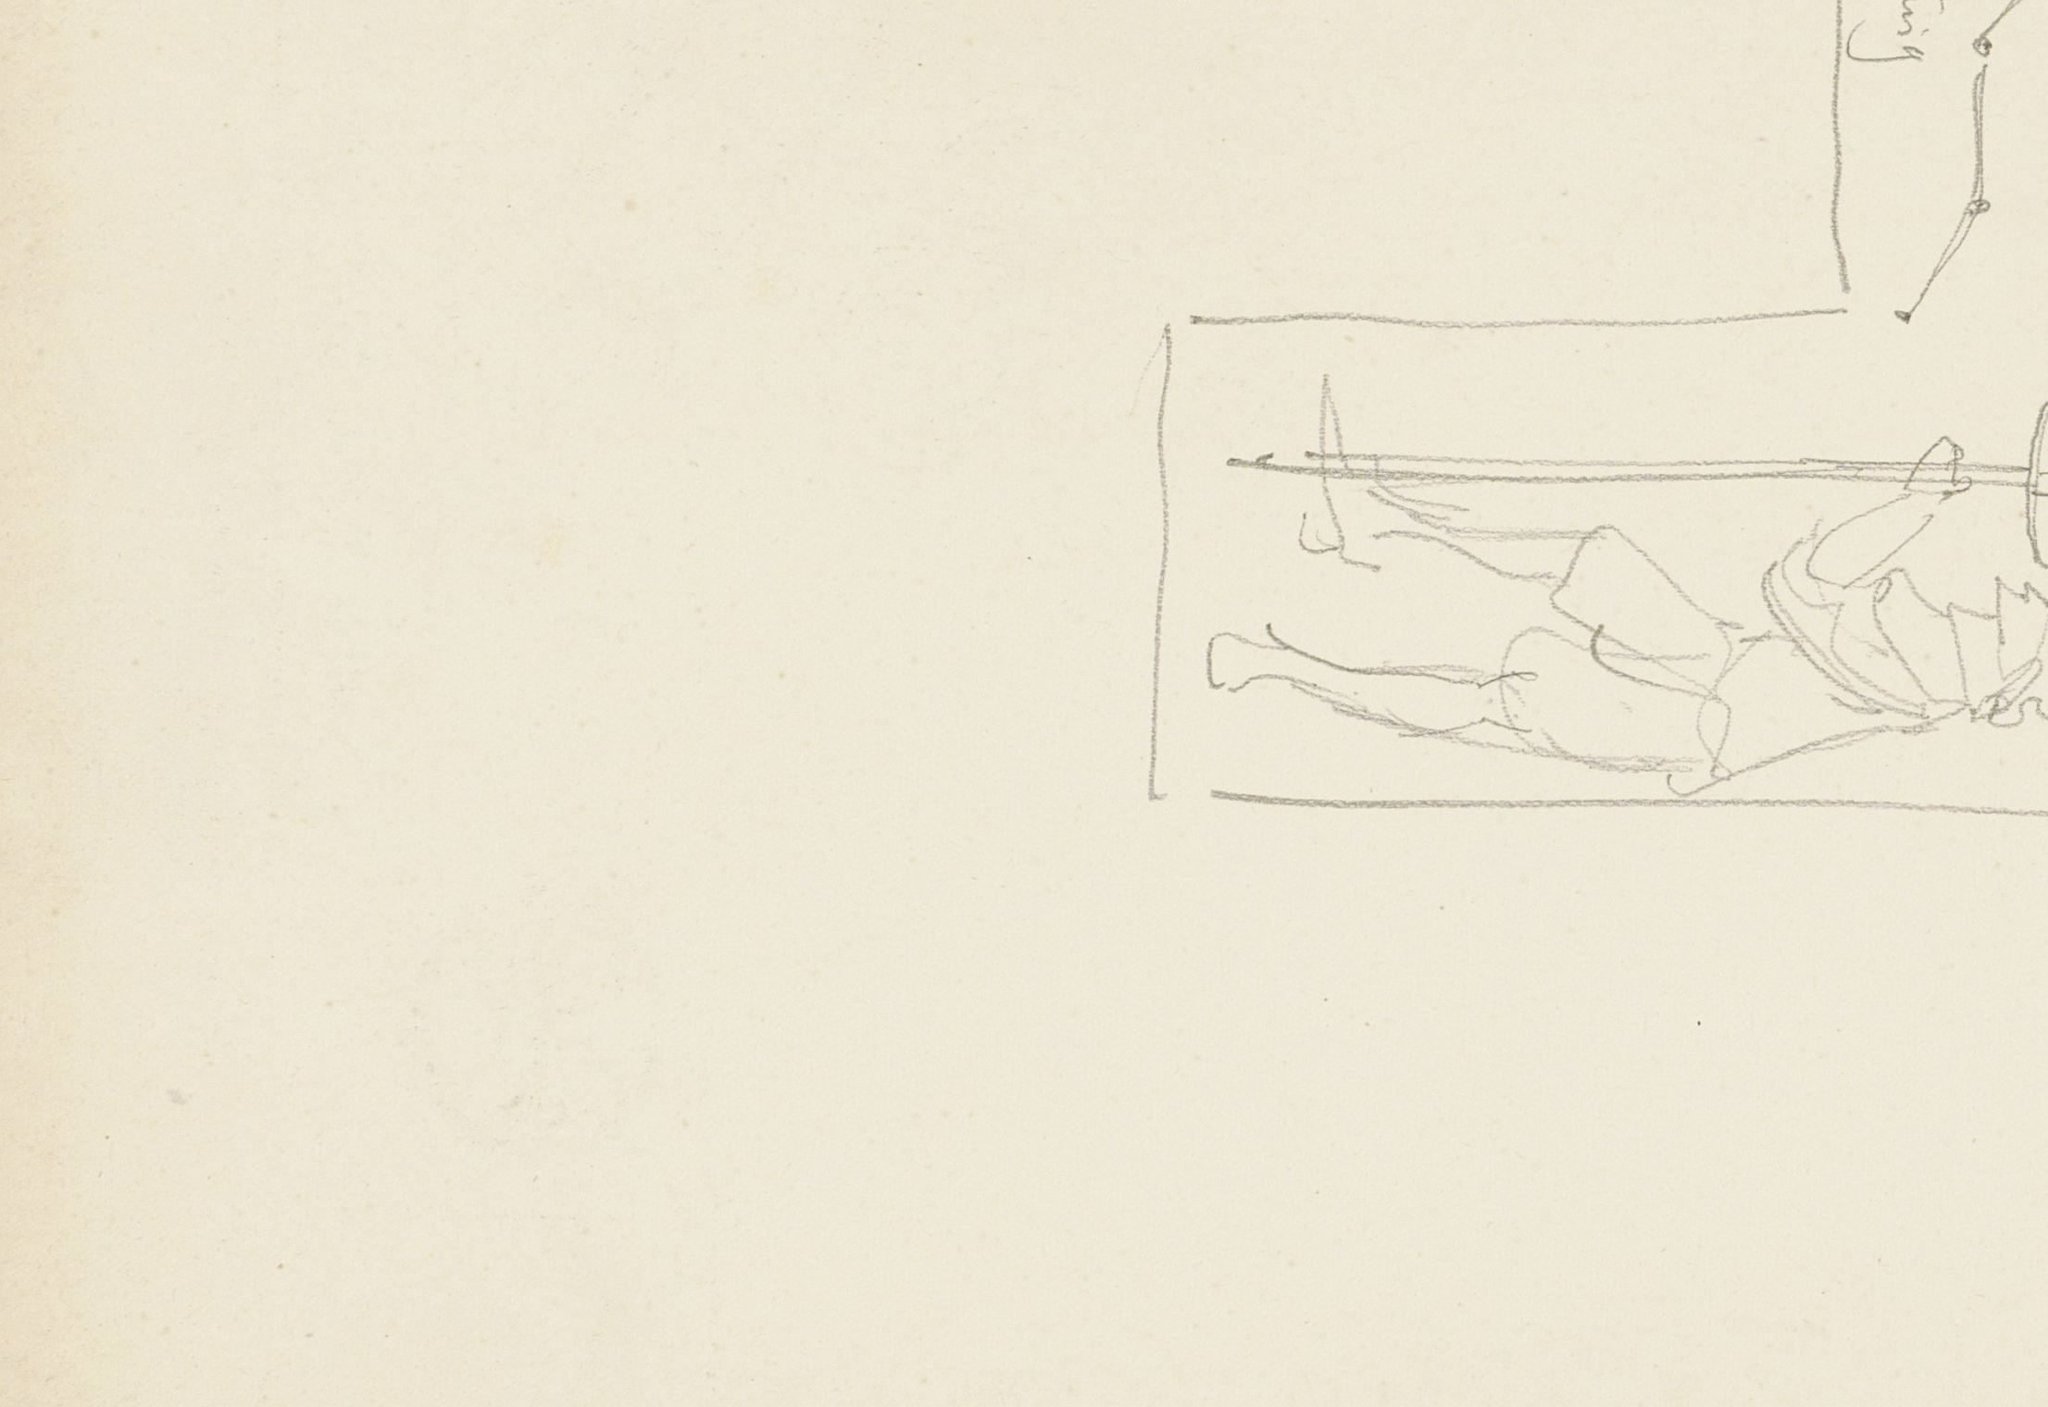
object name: sketchbook leaf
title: Man met die zonlicht opvangt met een optisch instrument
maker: antoon derkinderen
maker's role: draughtsman, painter, print maker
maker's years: 1859-1925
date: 1900-1903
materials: paper, pencil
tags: measuring-instruments, optical instruments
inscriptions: annotation: ‘land./ man met/ zonne - richt bundel?/ landme[...] instrumenten/ ketting’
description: Tevens een studie van een man met in zijn hand een paal met daarop een schijf waaruit een ketting komt. Mogelijk een instrument om land te meten. Blad 43 verso uit een schetsboek met 45 bladen.